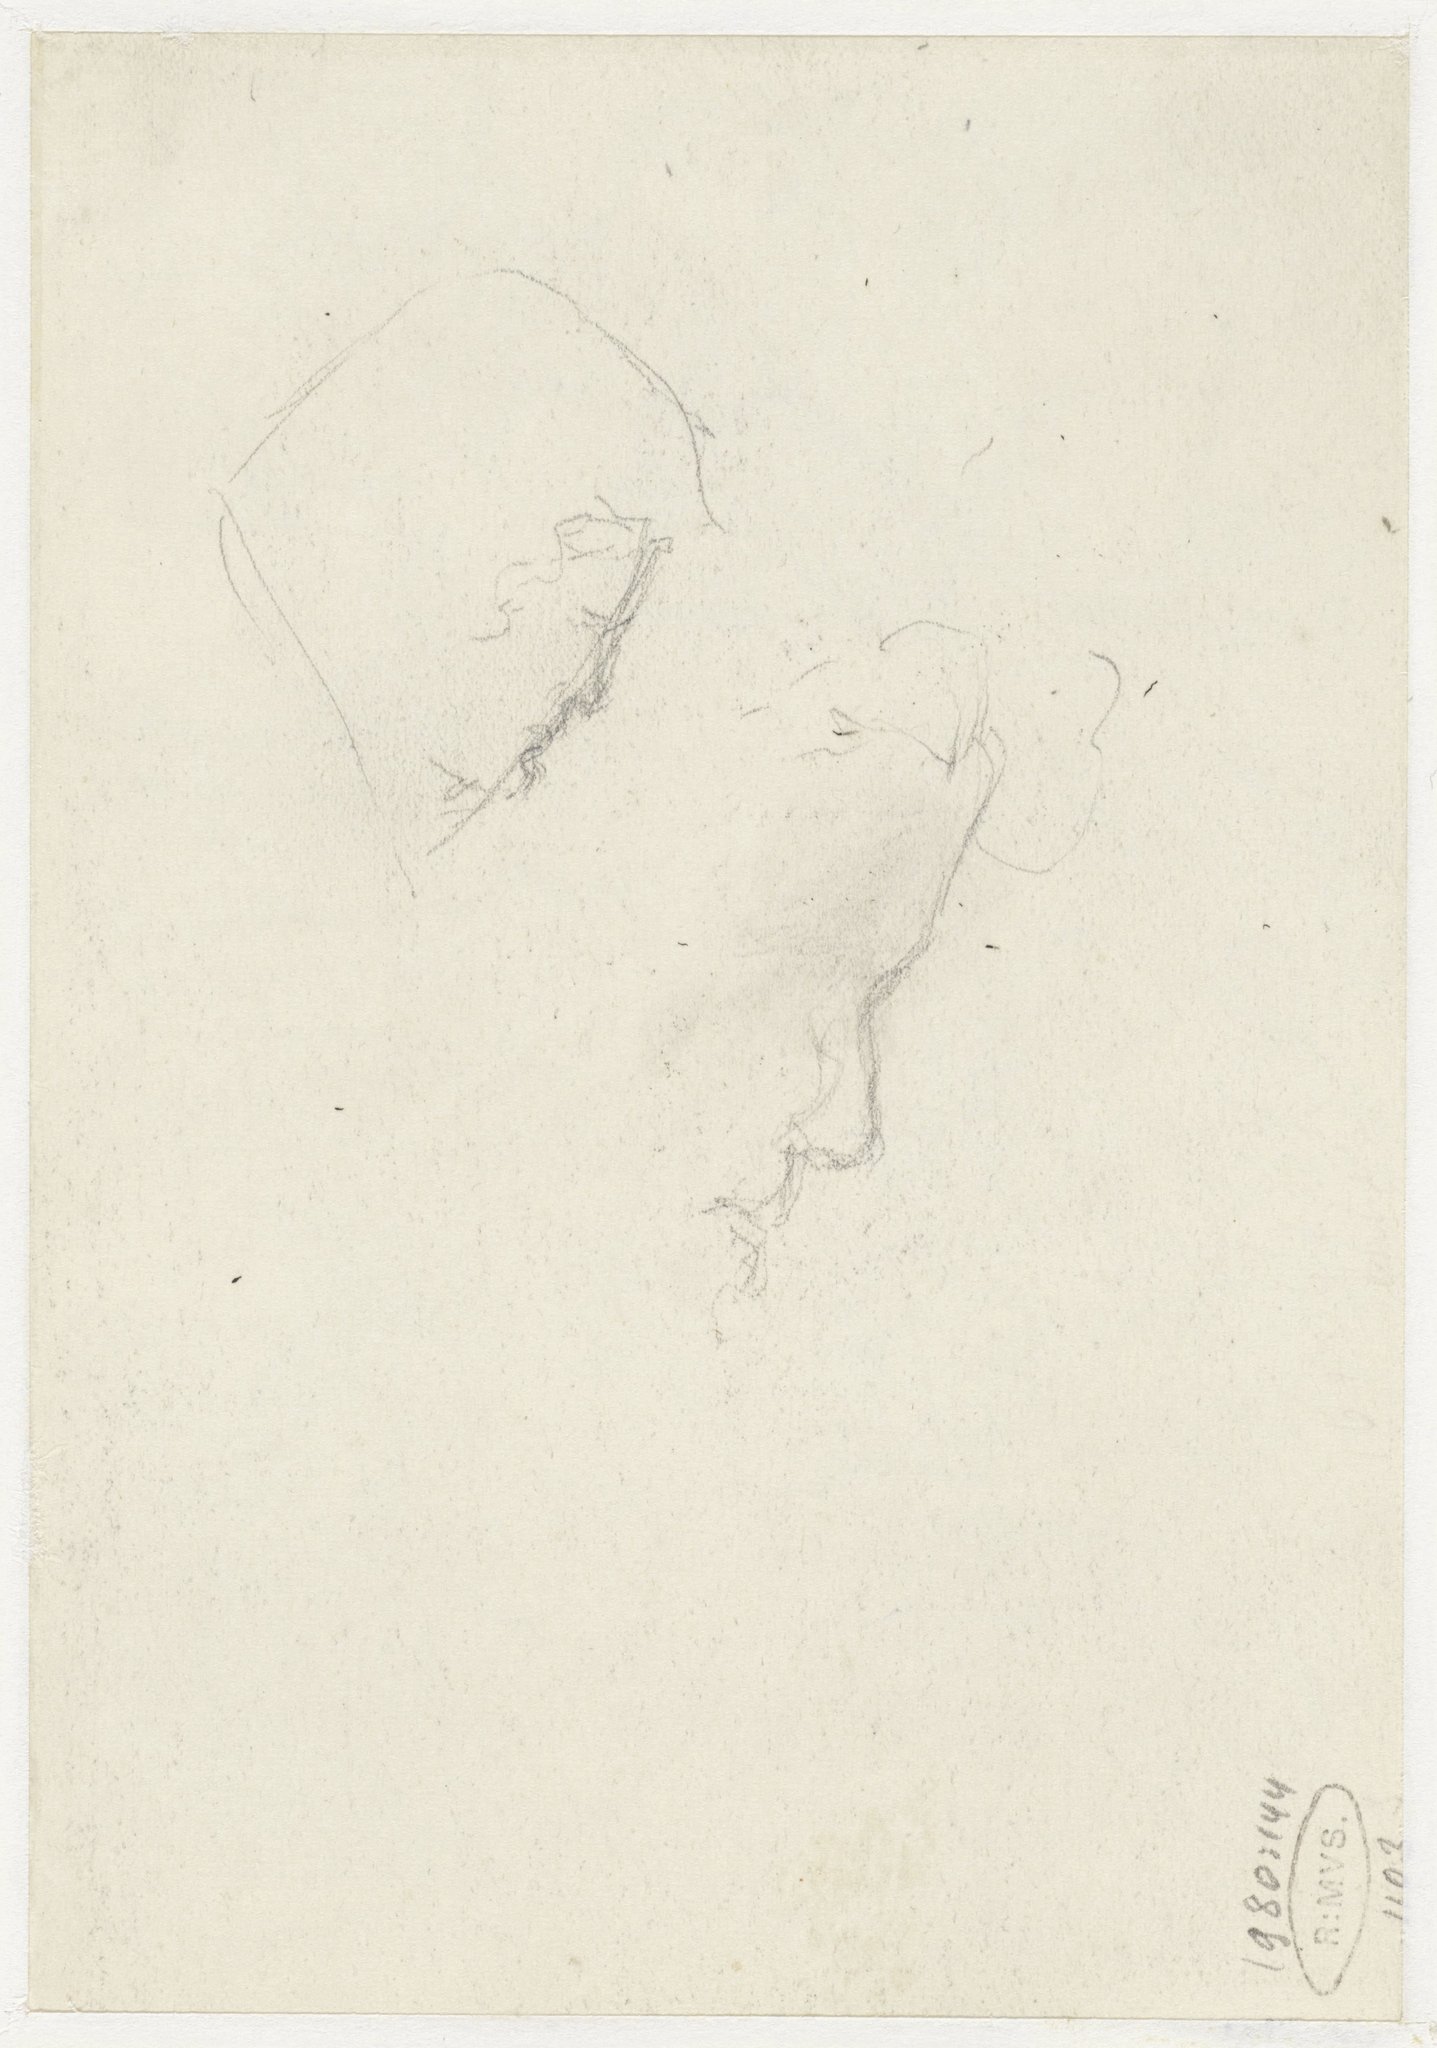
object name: drawing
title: Schetsen van een hoofd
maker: jozef israëls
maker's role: draughtsman, painter, print maker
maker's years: 1824-1911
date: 1834-1911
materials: paper, pencil